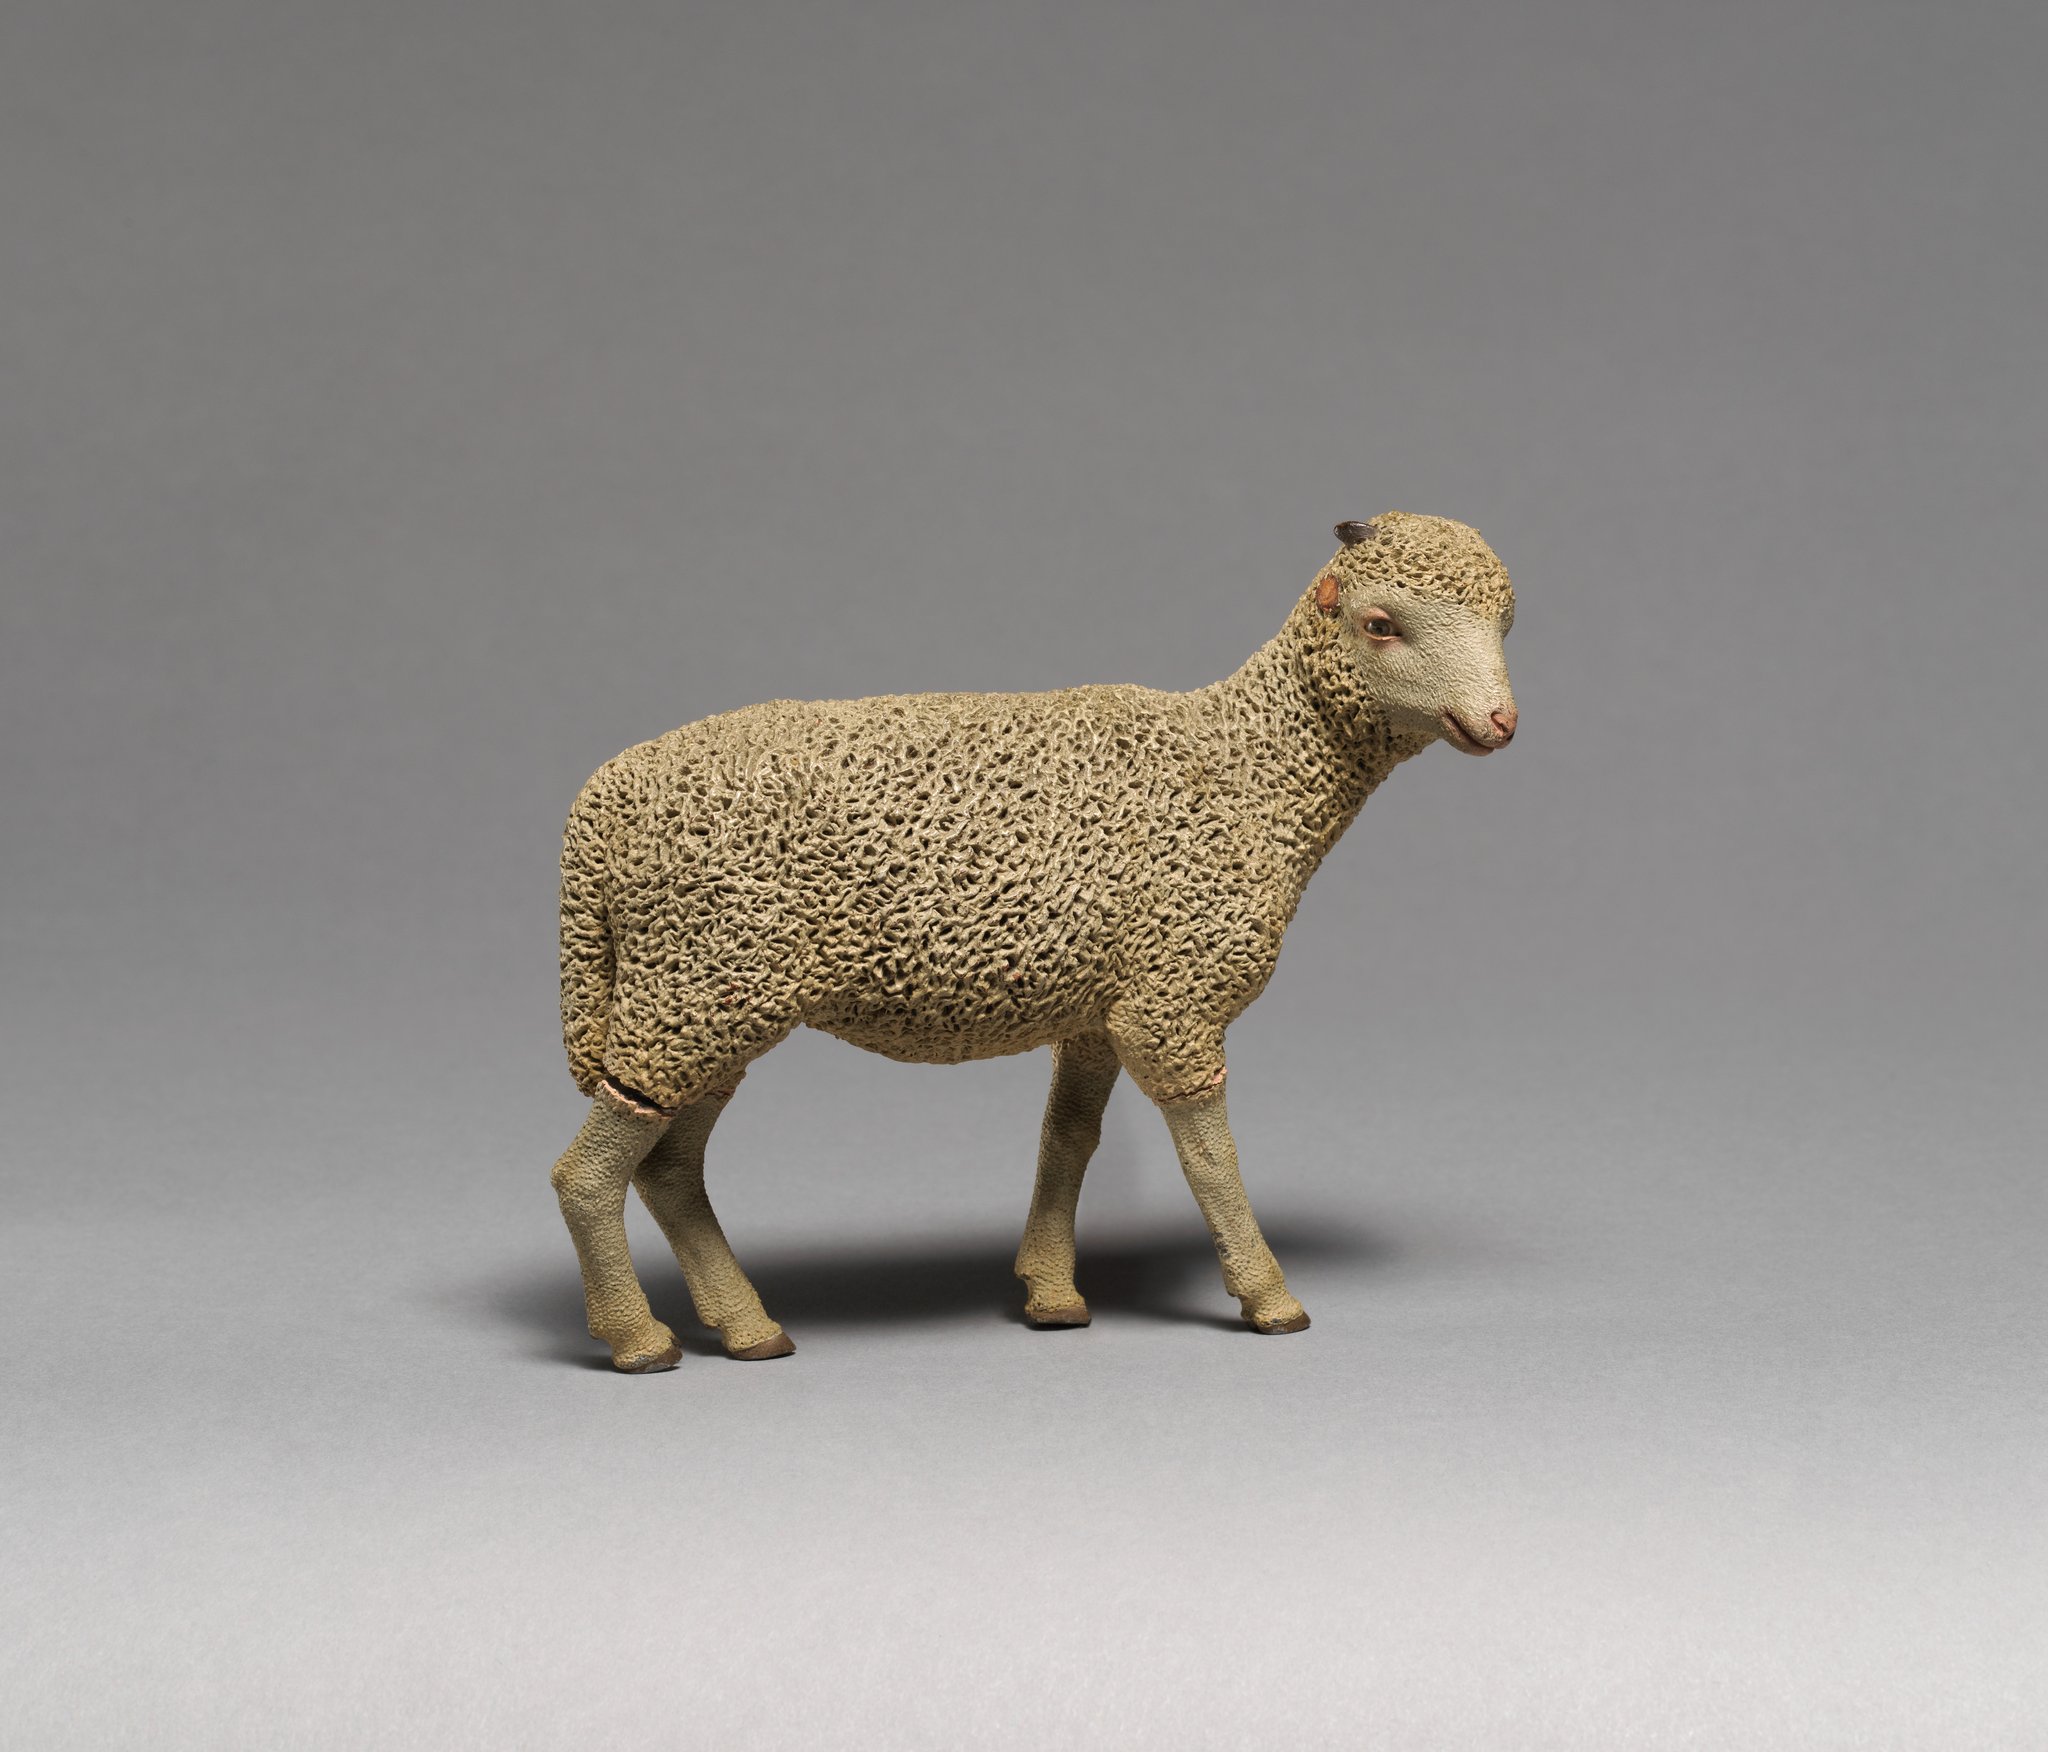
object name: crèche figure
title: Sheep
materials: terracotta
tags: sheep